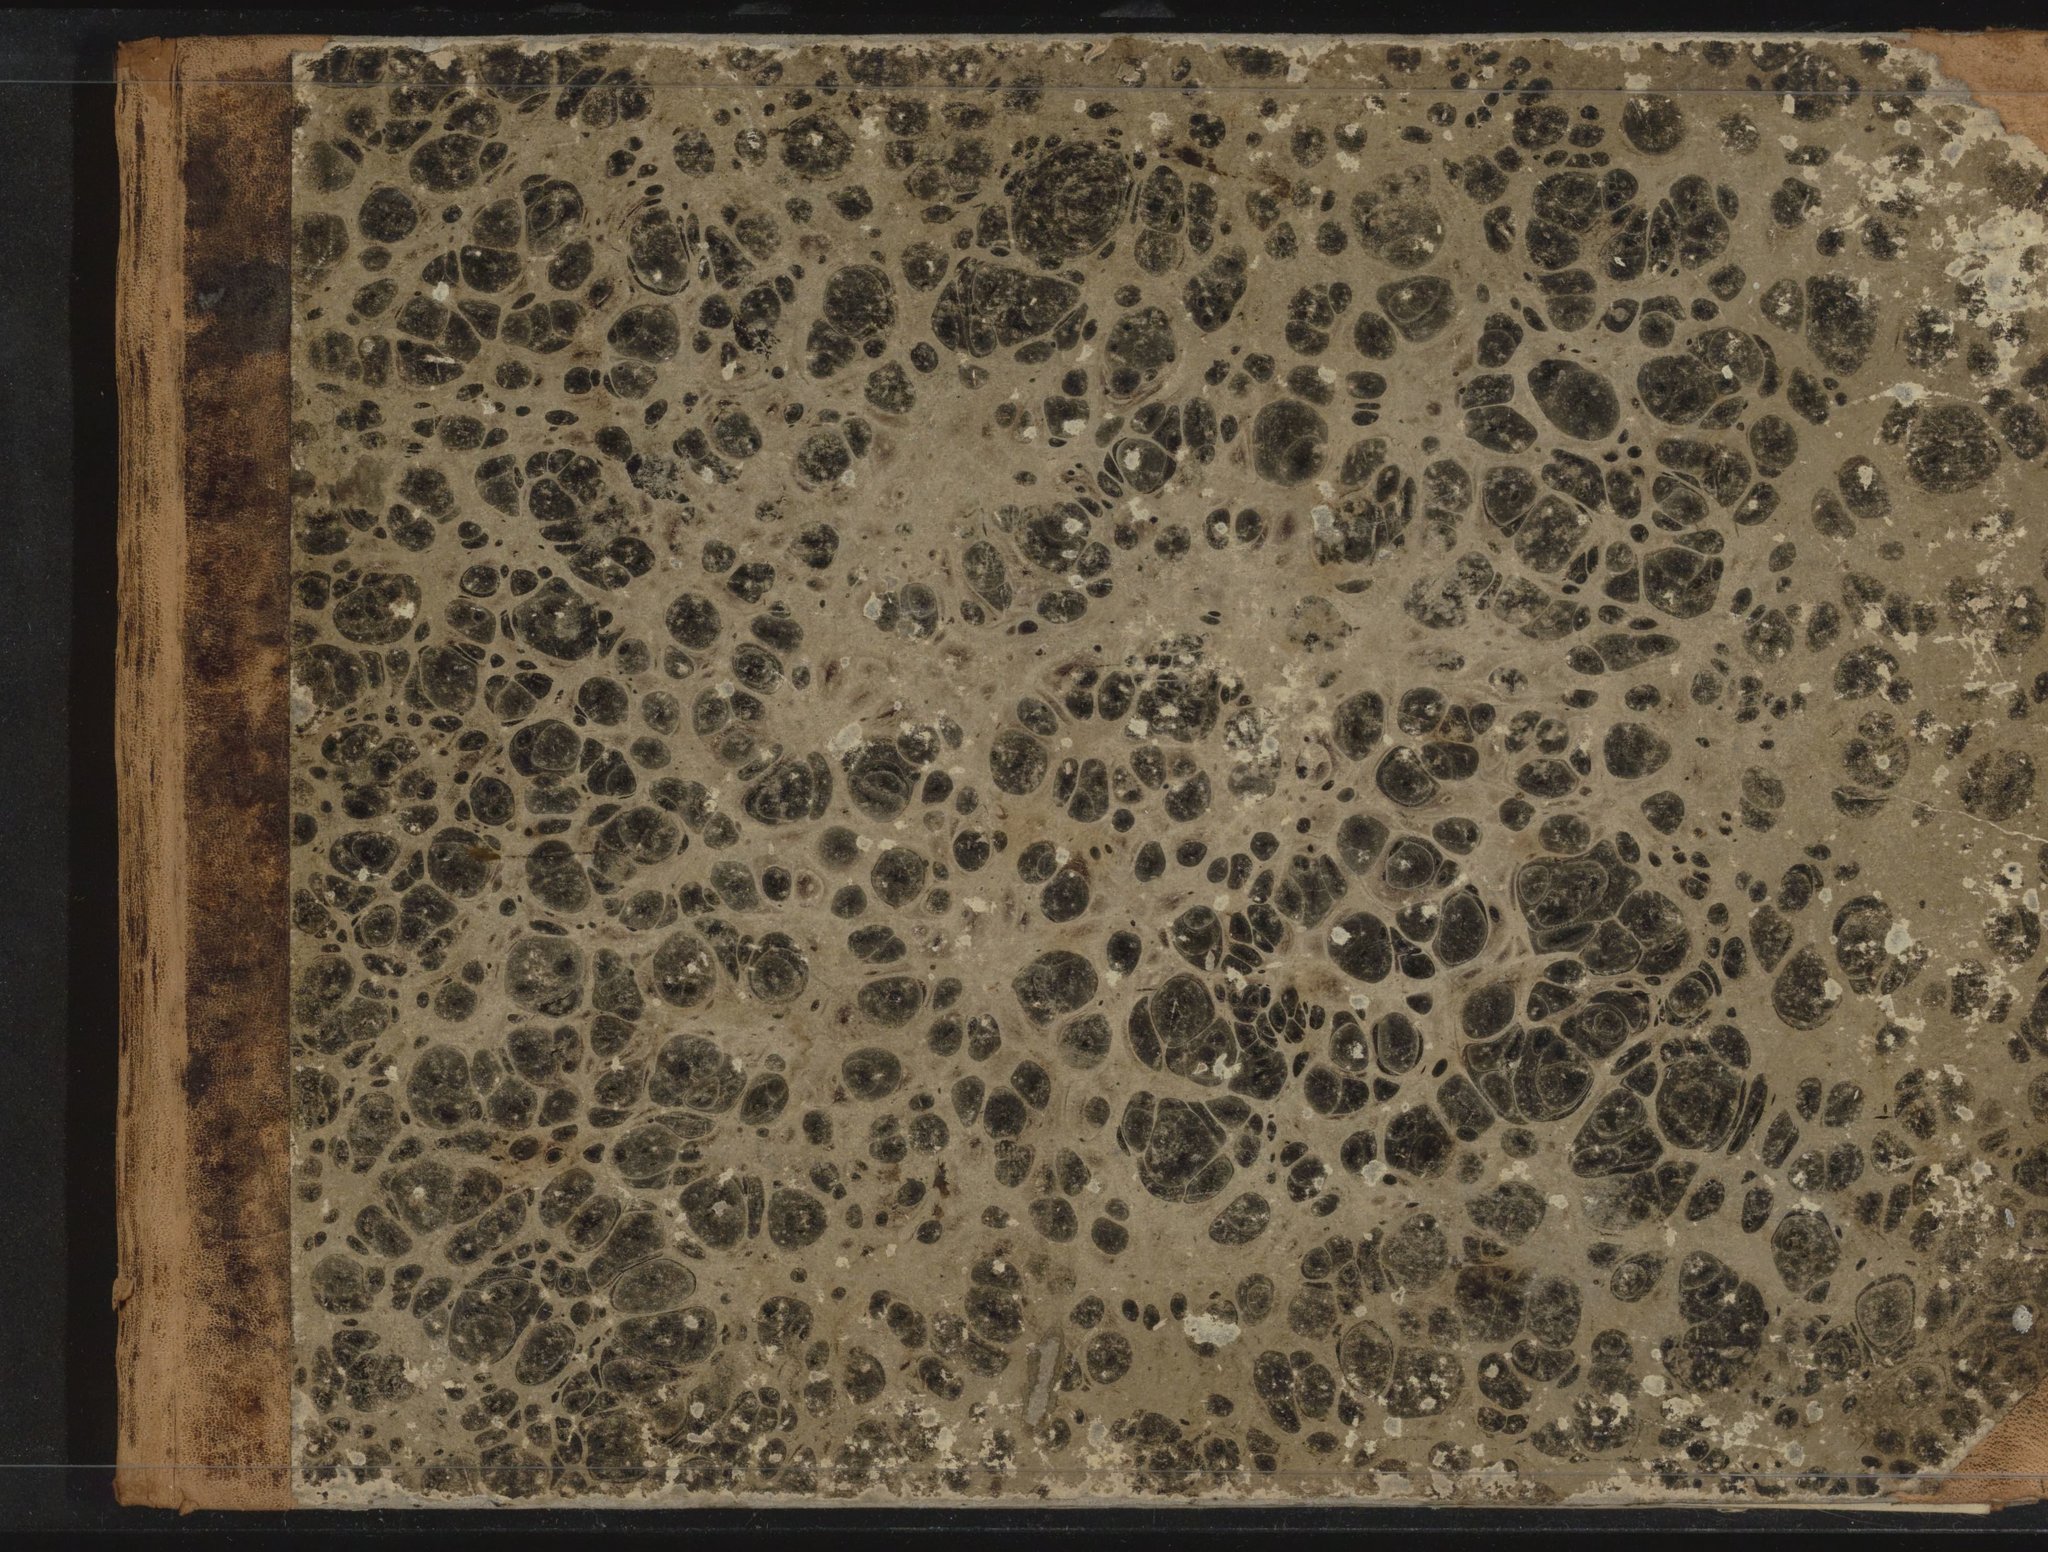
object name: sketchbook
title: Schetsboek met 43 bladen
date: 1840-1845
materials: cardboard, chalk, leather, paper, pencil, watercolor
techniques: brush, scoring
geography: schwarzburg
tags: city-view, and landscape with man-made constructions, landscapes, anatomy (non-medical), brussels, cleves, brabant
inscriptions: signature and date: ‘J. Tavenraat./ Rotterdam. 1840.’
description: Schetsboek bestaande uit 43 bladen met voornamelijk landschappen en stadsgezichten in België en Kleef, kopieën naar zeventiende-eeuwse Hollandse schilderijen in het museum te Kassel en figuurstudies van boeren en mannen en vrouwen in klederdracht. Tevens een schets van boerderijen door Samuel Verveer.